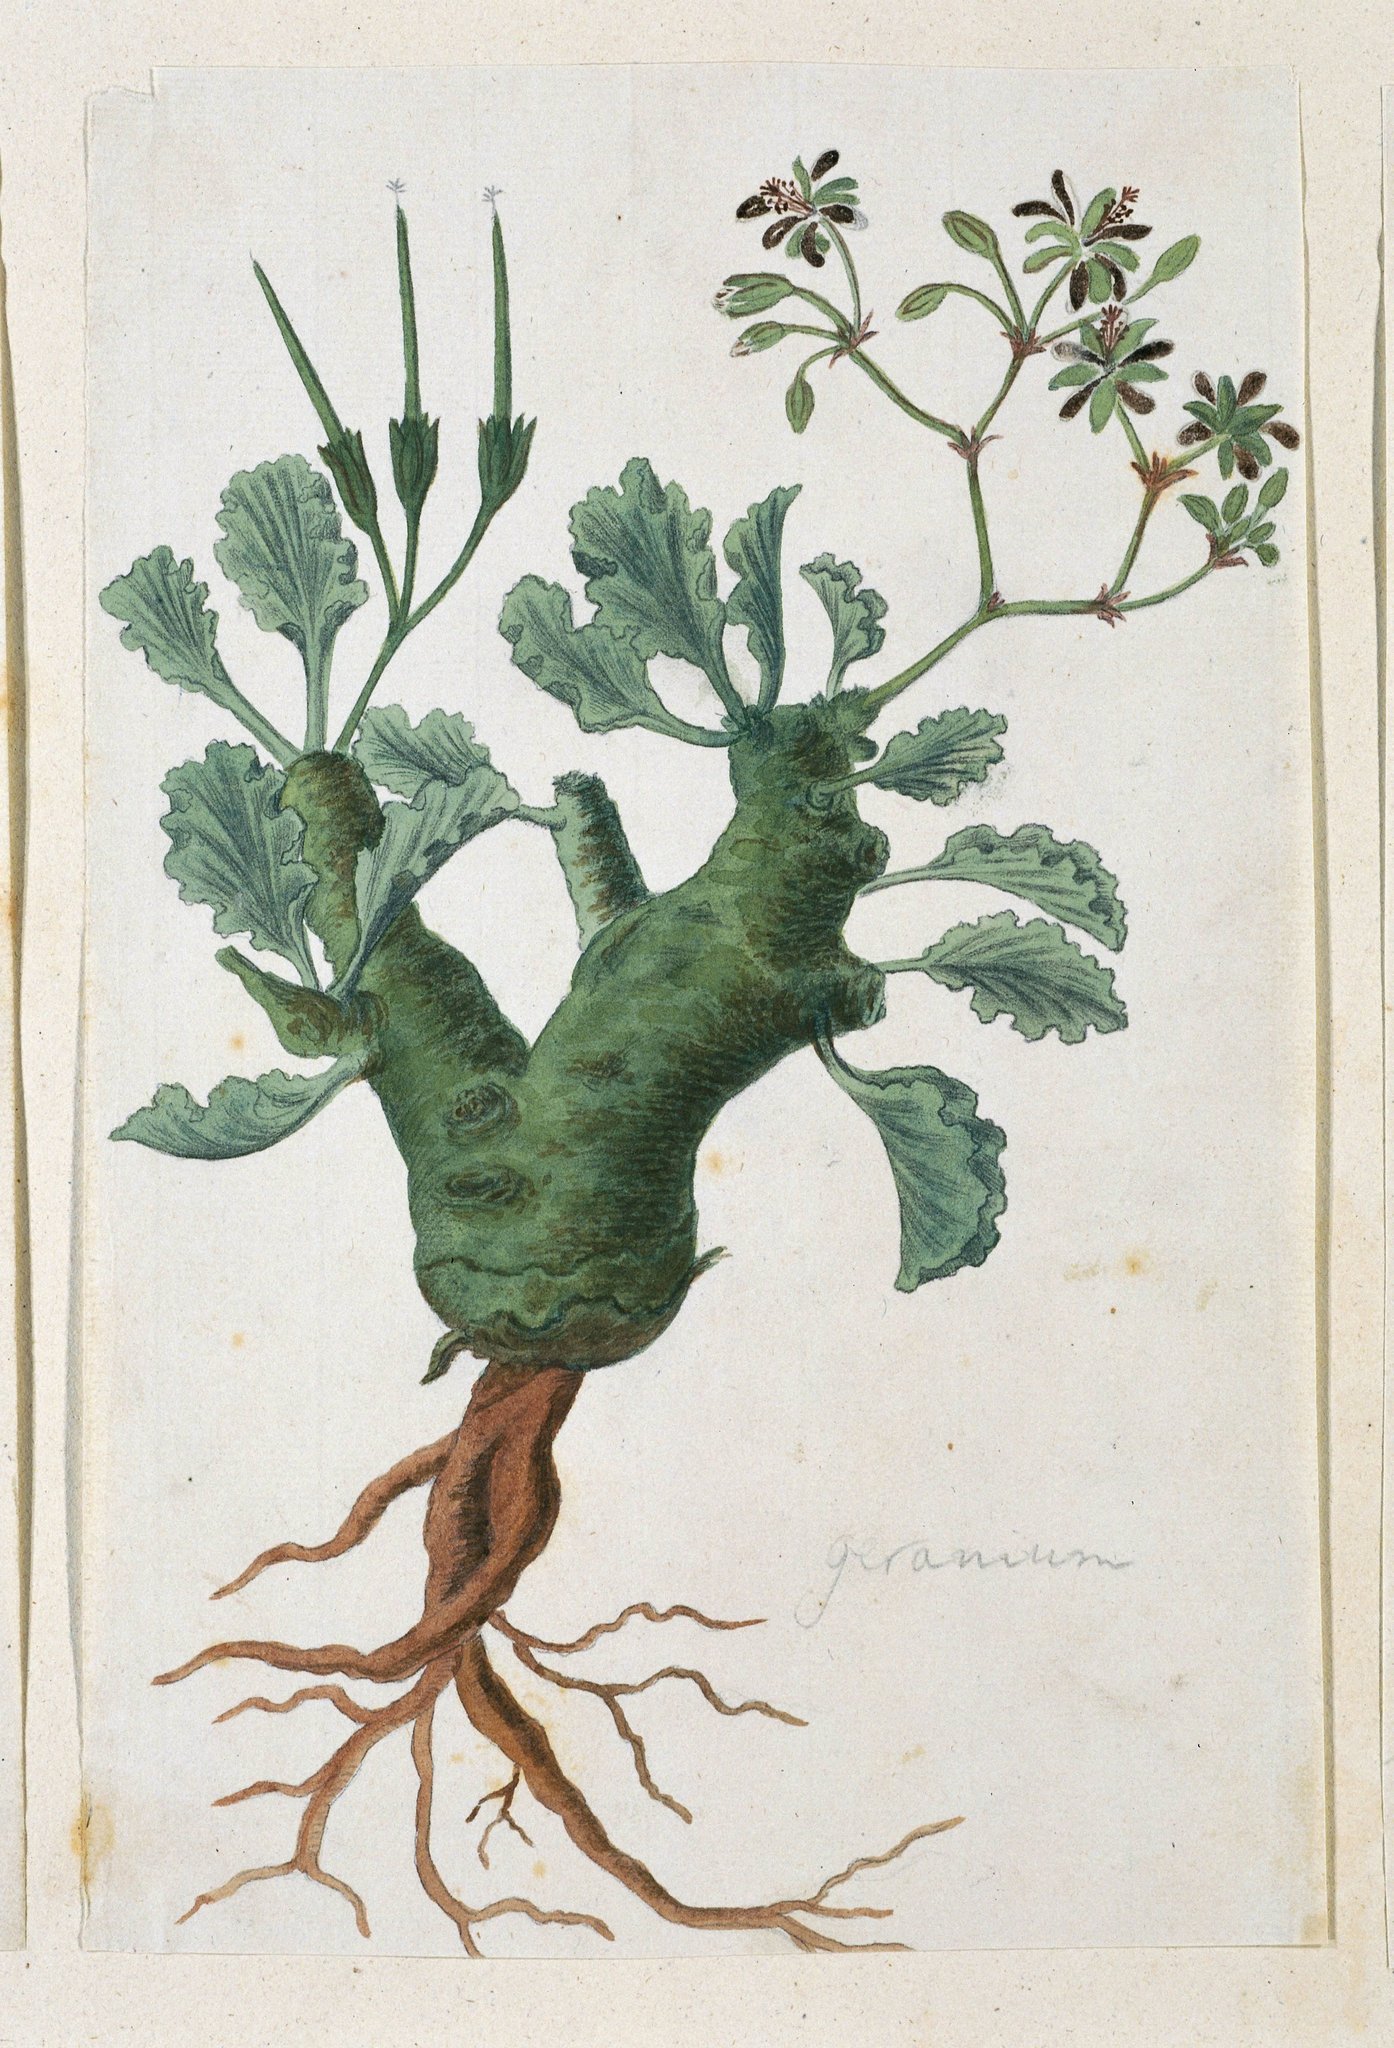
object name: drawing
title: Pelargonium klinghardtense Knuth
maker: robert jacob gordon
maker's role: draughtsman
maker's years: 1743-1795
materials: chalk, paper, pencil, watercolor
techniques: brush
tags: plants; vegetation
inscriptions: annotation: ‘geranium’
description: De tekening is gemaakt voor of tijdens een van Gordon's vier expedities door de Kaapprovincie, van oktober 1777 tot maart 1786. Sommige (soort)namen kunnen zijn gewijzigd, gezien reorganisatie in plantentaxonomie gedurende de afgelopen jaren.